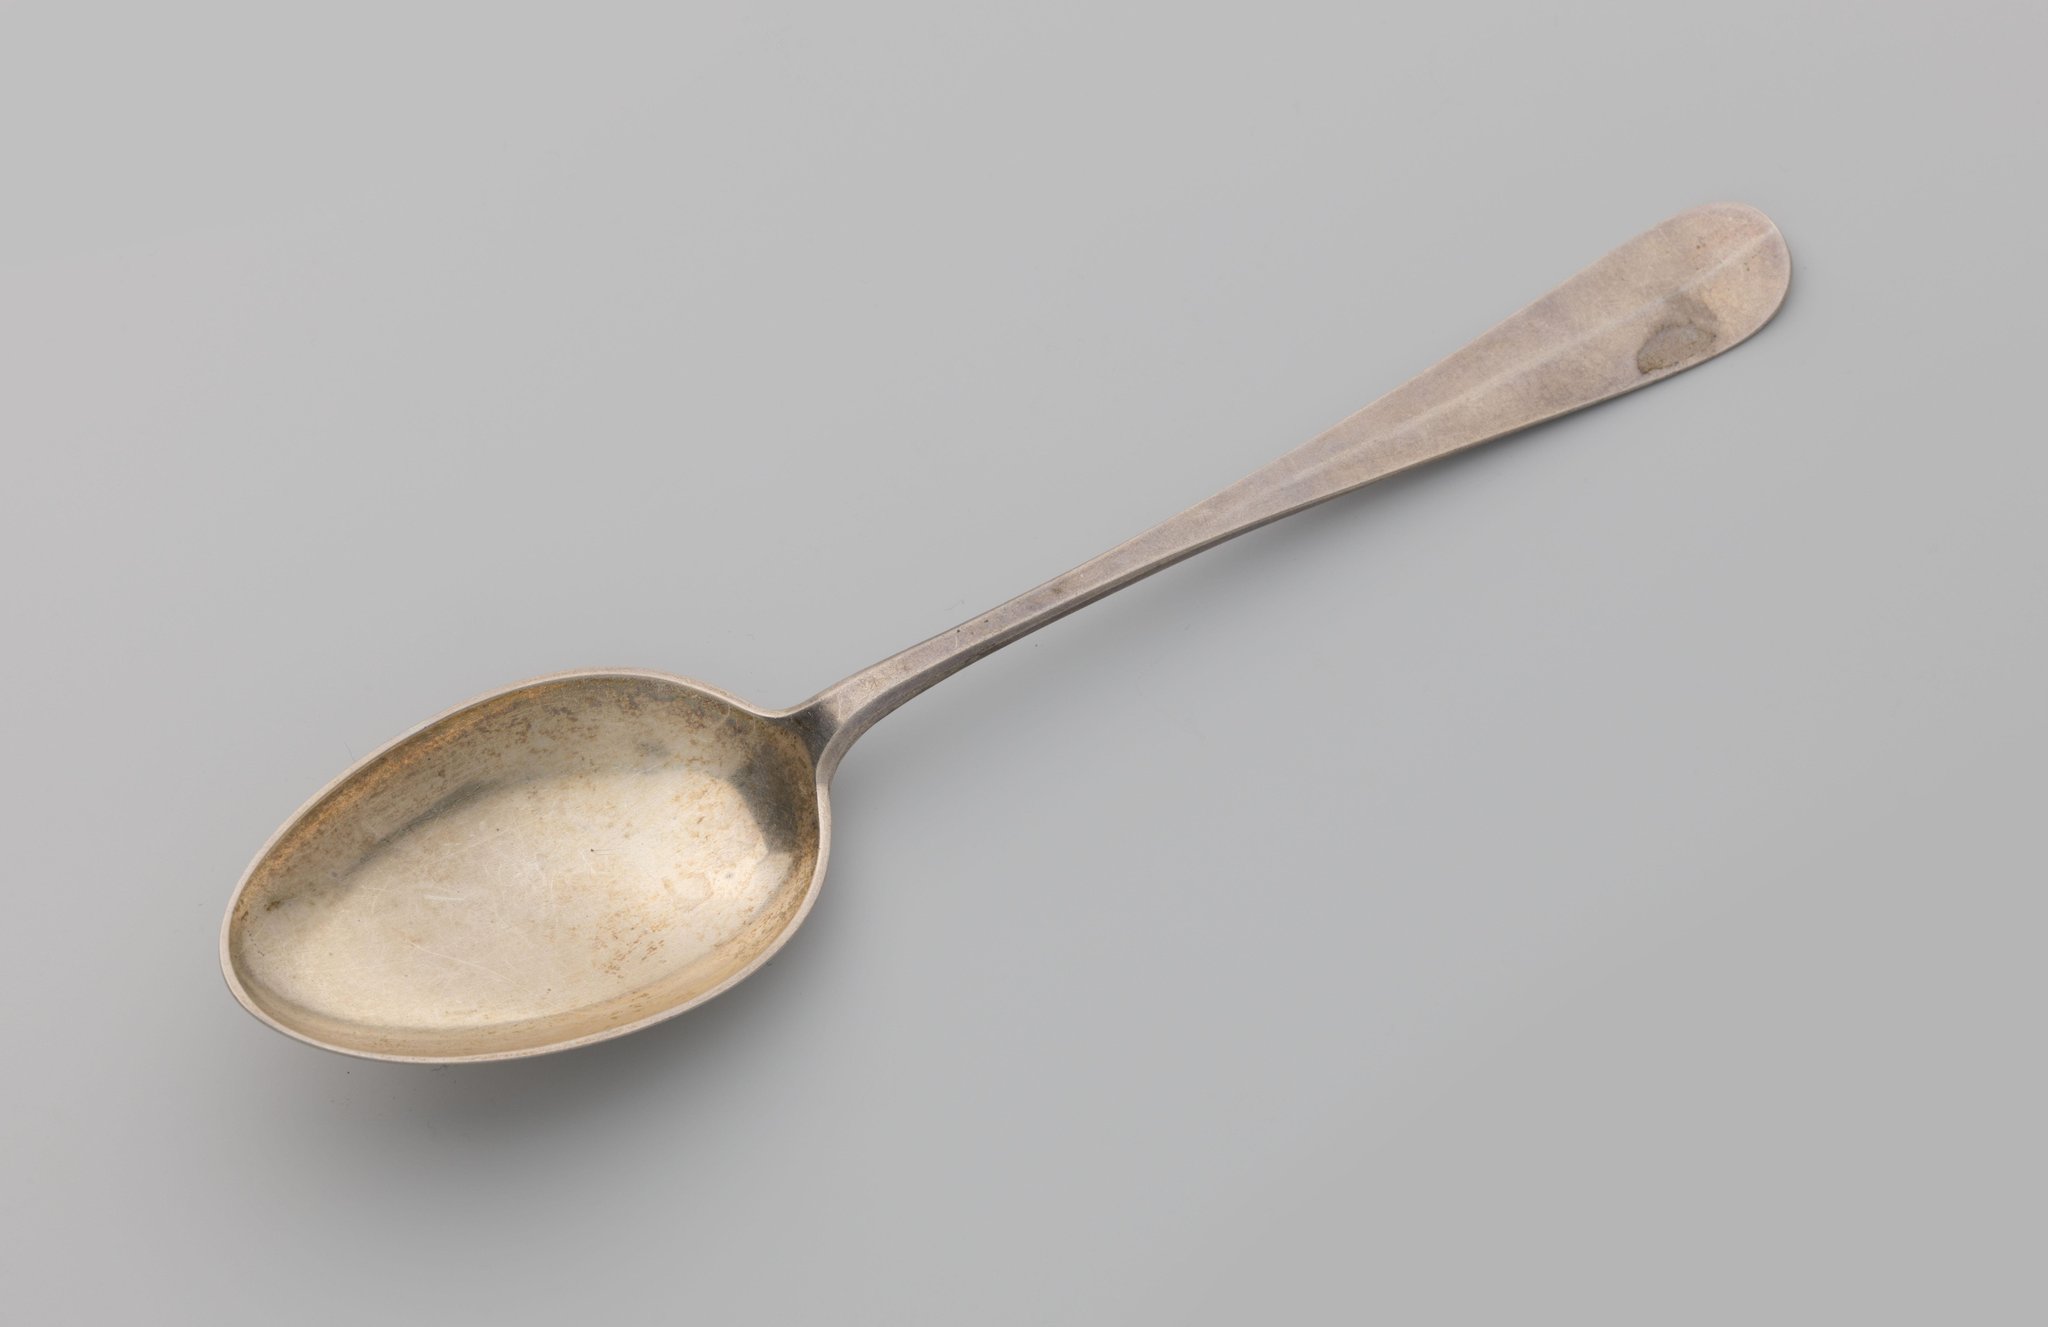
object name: spoon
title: Lepel met jaartal 1836.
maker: willem roelfsema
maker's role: silversmith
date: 1836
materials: silver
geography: winsum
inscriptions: mark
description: Lepel van zilver, met eivormige bak. Op de onderzijde van de steel is ingeponst: H.T.K./ T.A.H./1836